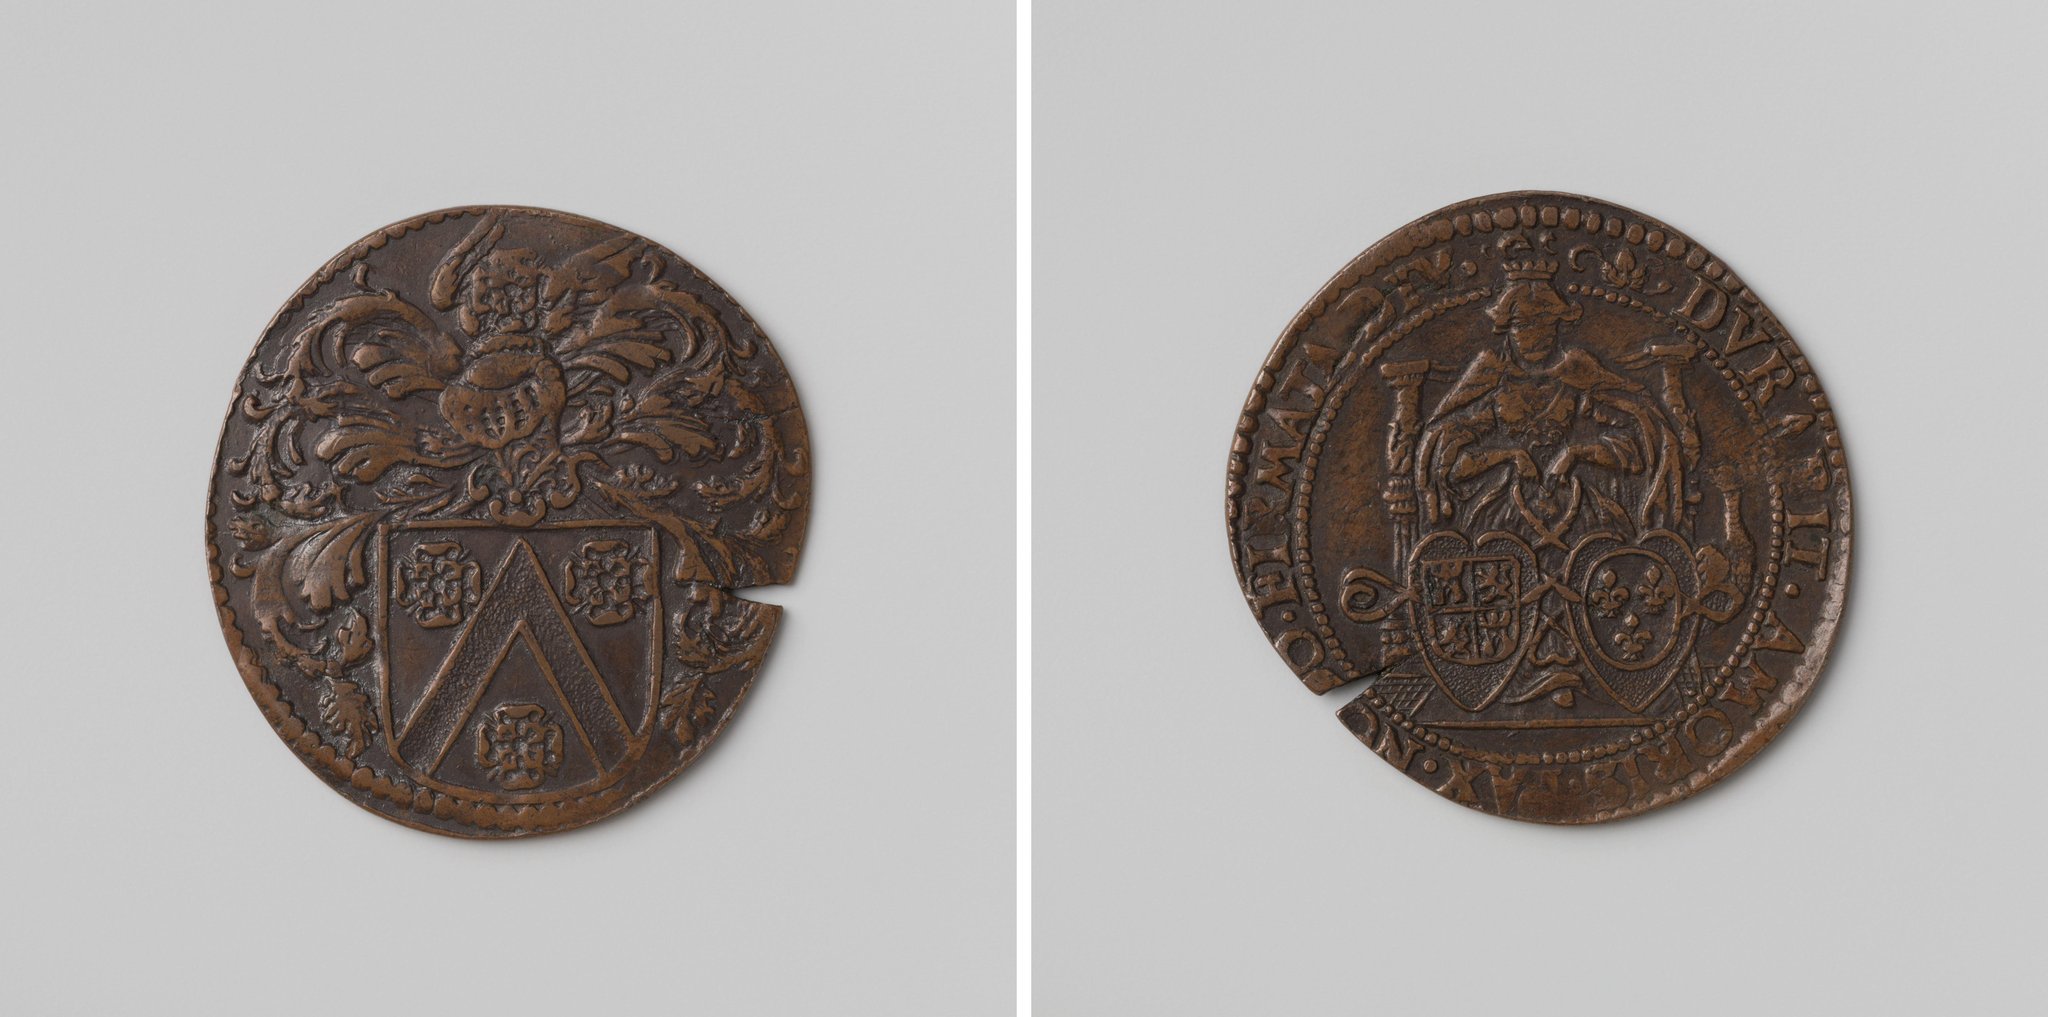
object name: jeton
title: Huwelijk van Karel II, koning van Spanje met Marie Louise van Orleans, rekenpenning van Jean Heymans, magistraat van de schatkist van Brussel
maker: Anonymous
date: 1680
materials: copper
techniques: striking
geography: brussels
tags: karel ii (koning van spanje), brussels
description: Koperen penning. Voorzijde: gehelmd wapenschild. Keerzijde: gekroonde vrouw, voorstellende Juno, zittend op troon met aan haar voeten twee wapenschilden binnen omschrift